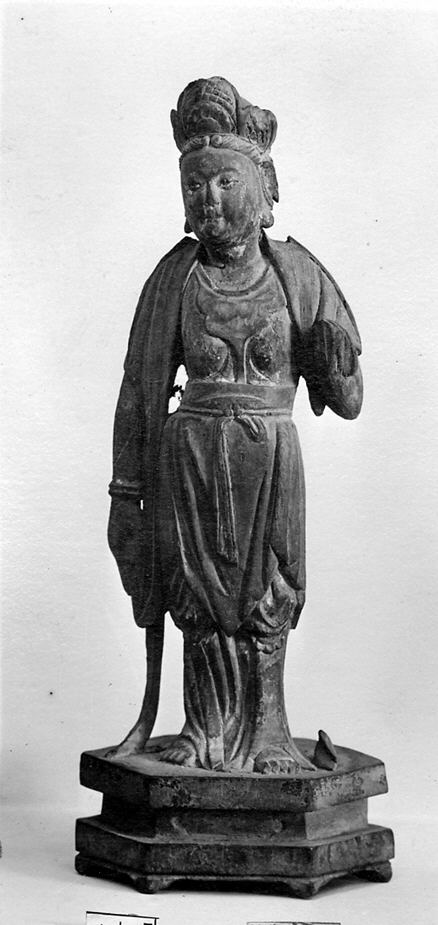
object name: statuette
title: Statuette of Bodhisattva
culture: chinese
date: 1368-1644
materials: wood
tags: bodhisattvas